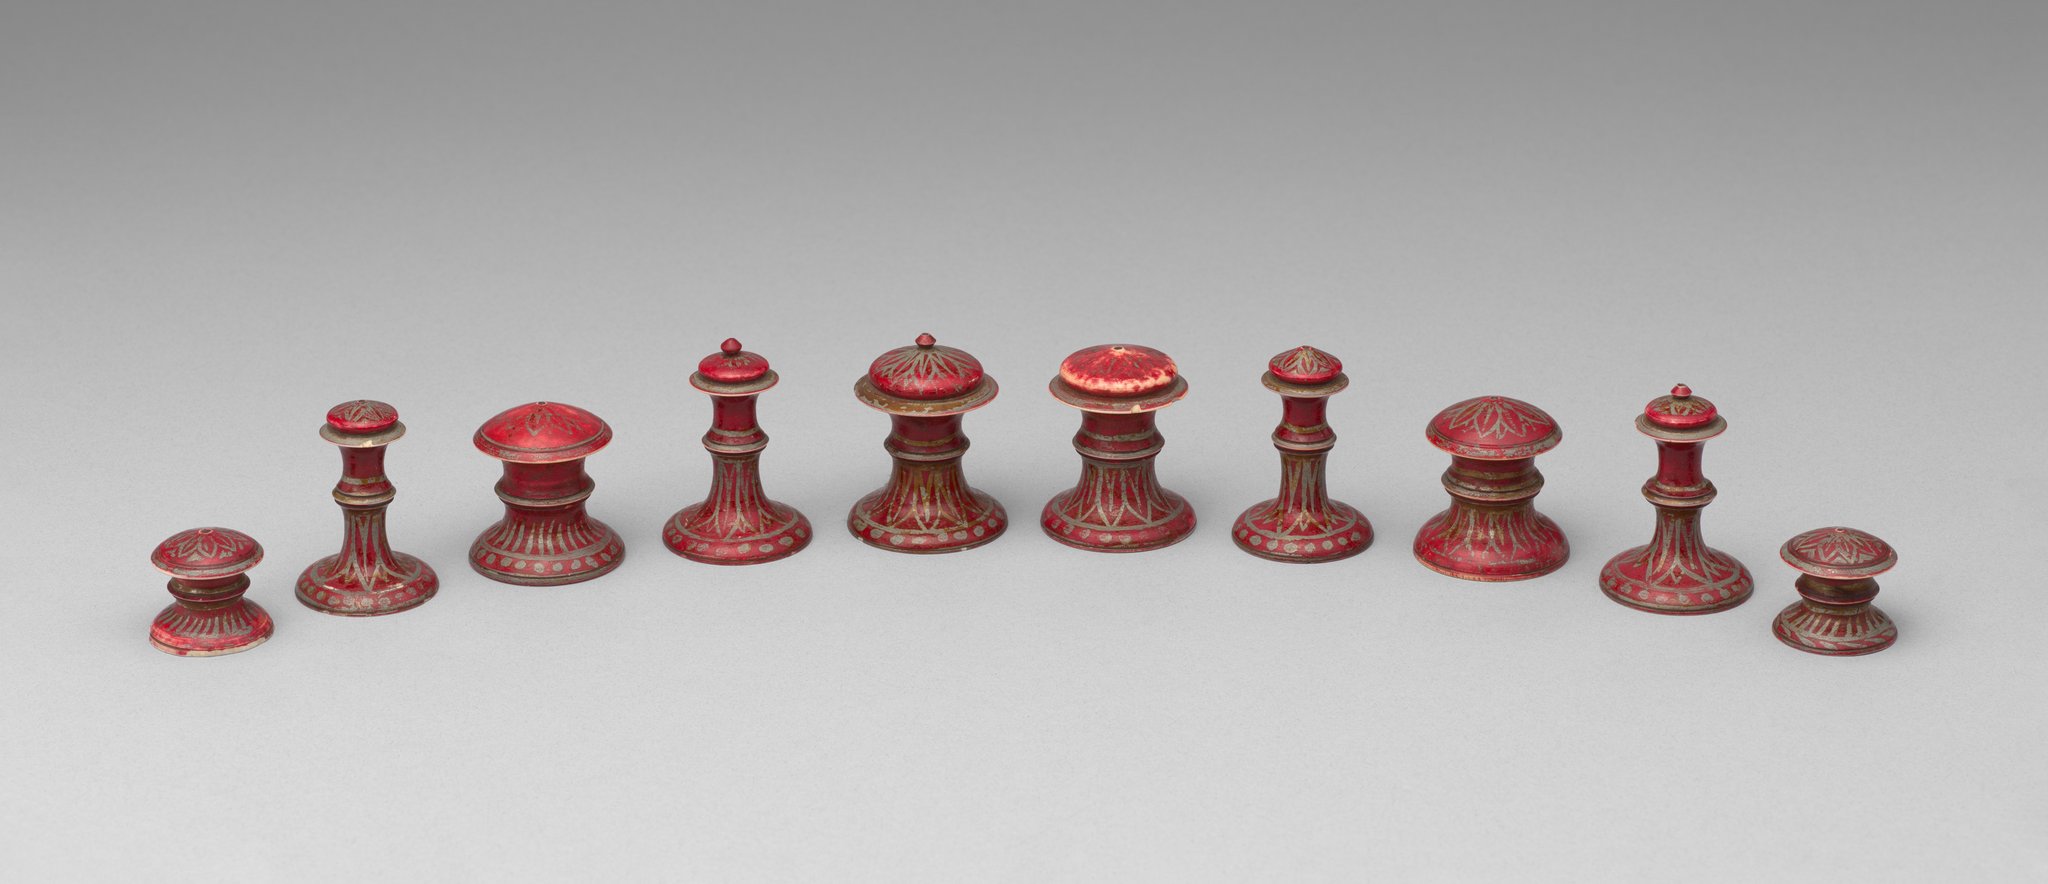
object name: chessman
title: Chessmen (32)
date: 1701-1800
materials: ivory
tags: chess